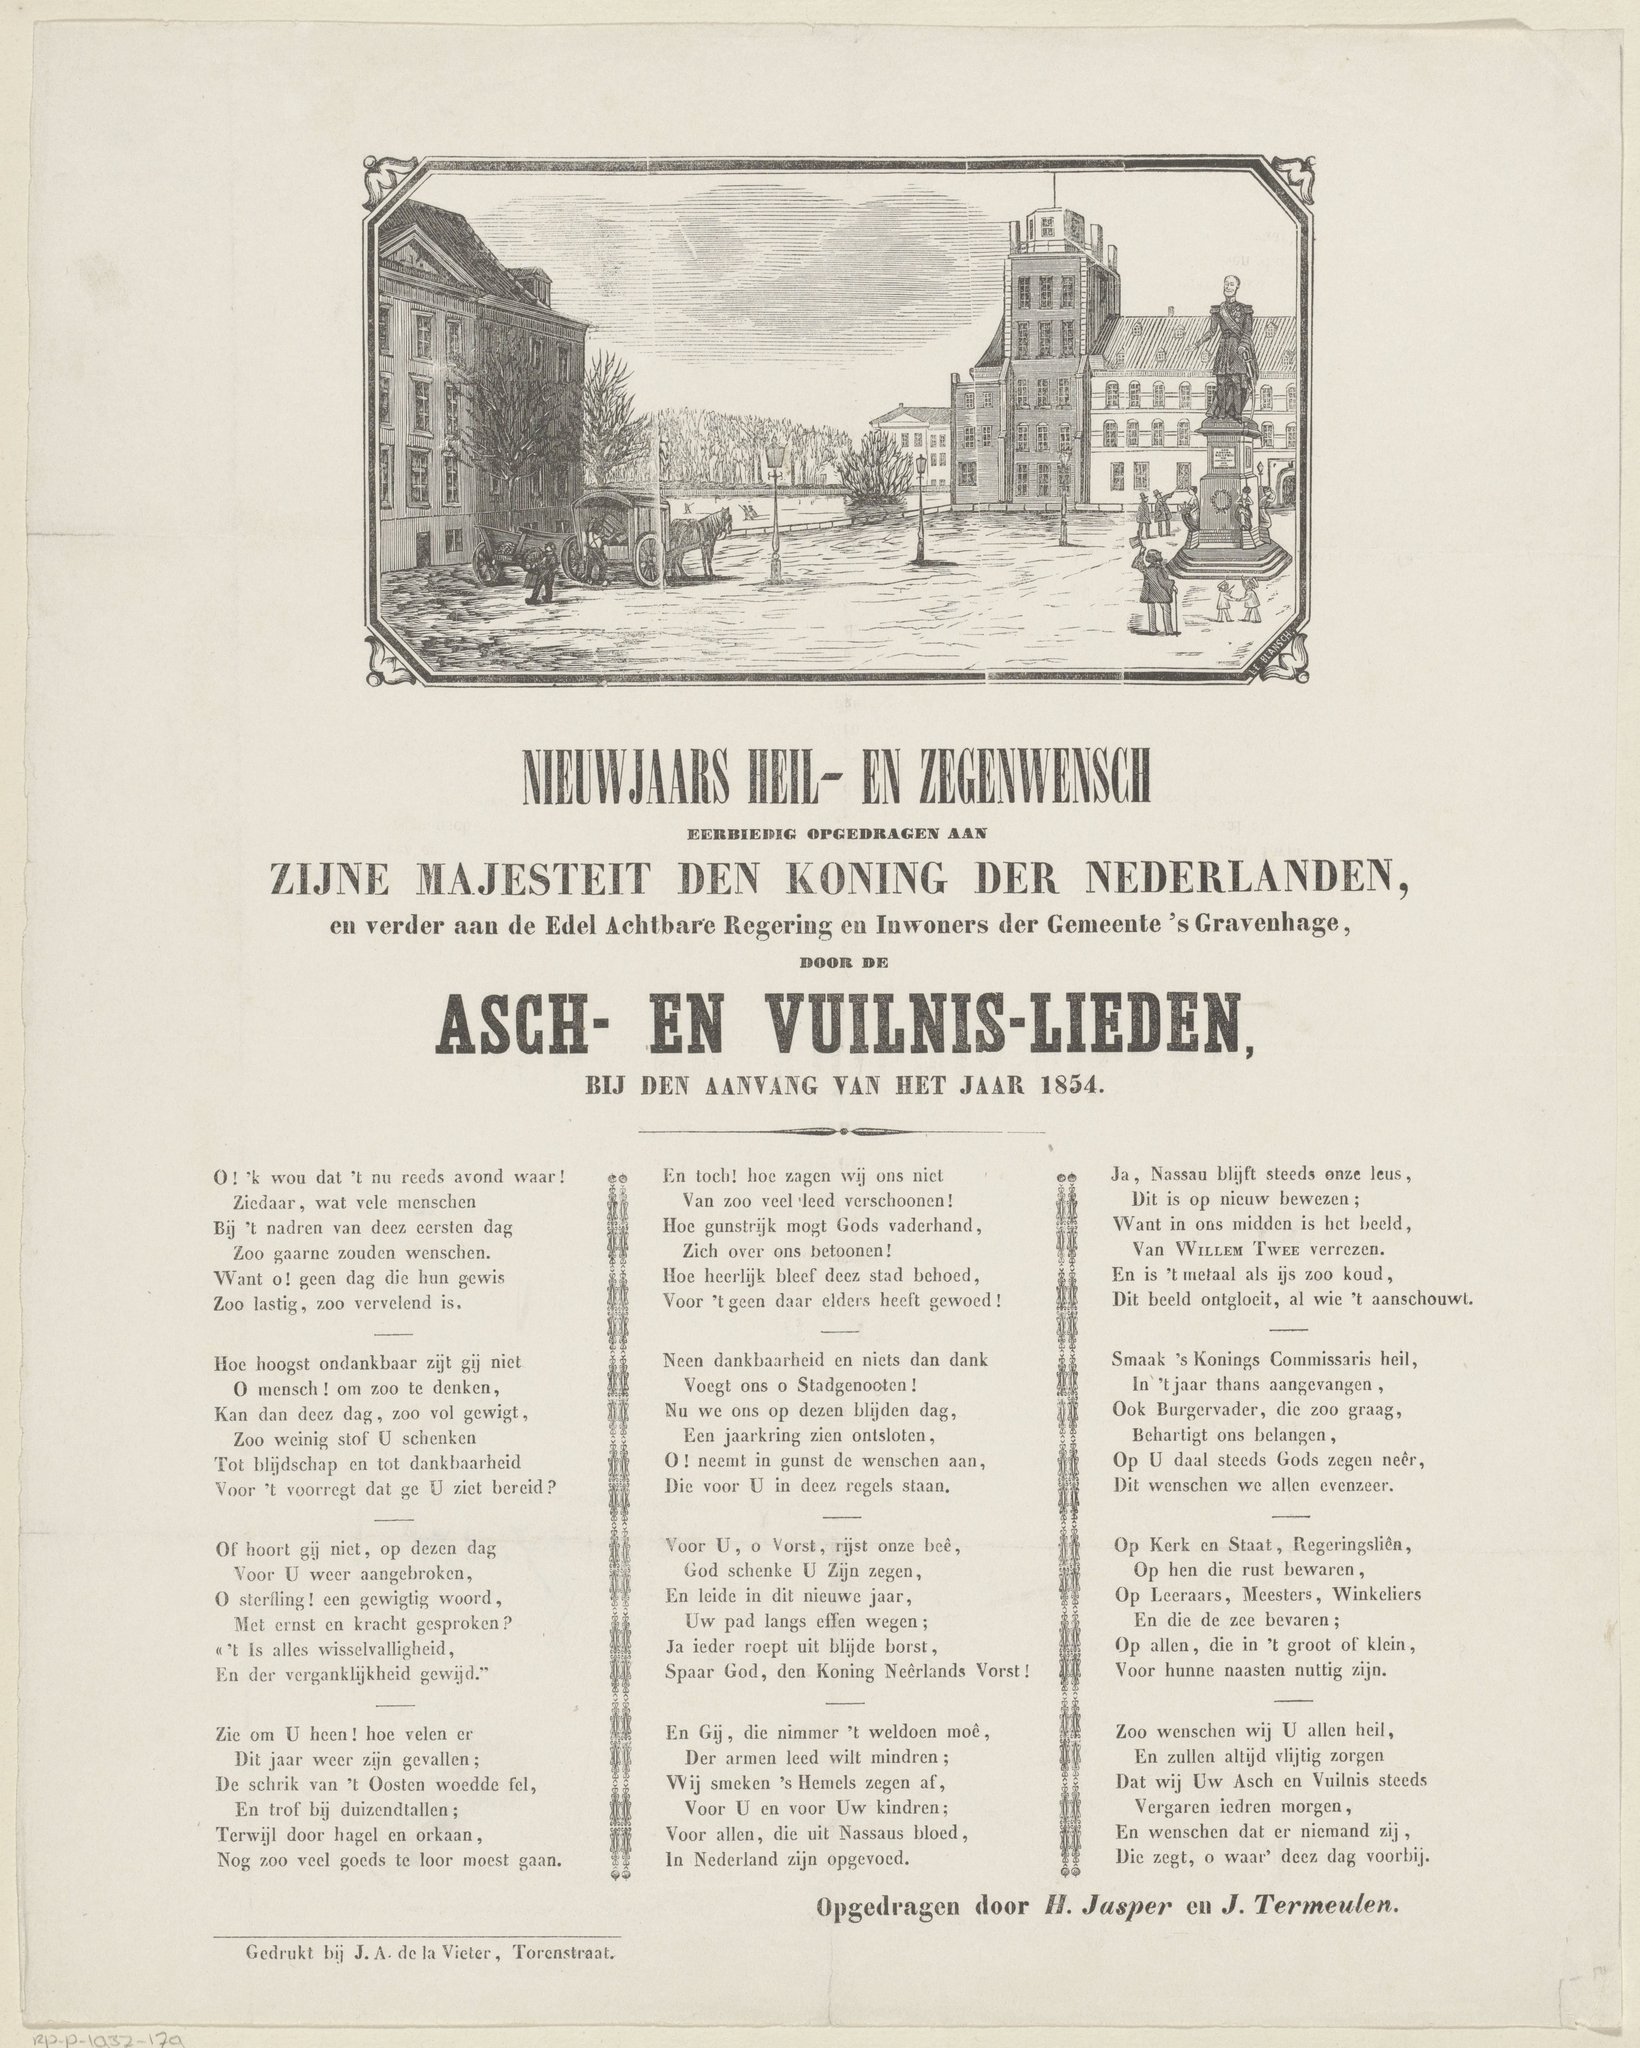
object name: new year card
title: Nieuwjaarswens van de as- en vuilnislieden van Den Haag voor het jaar 1854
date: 1854-1856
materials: paper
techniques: letterpress printing, engraving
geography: the hague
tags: garbage collection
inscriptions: collector's mark: Lugt 2760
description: Midden boven de as- en vuilnislieden aan het werk op het Buitenhof te Den Haag. Daaronder twaalf kolommen met elk zes regels Nederlandse tekst. Namens H. Jasper en J. Termeulen.